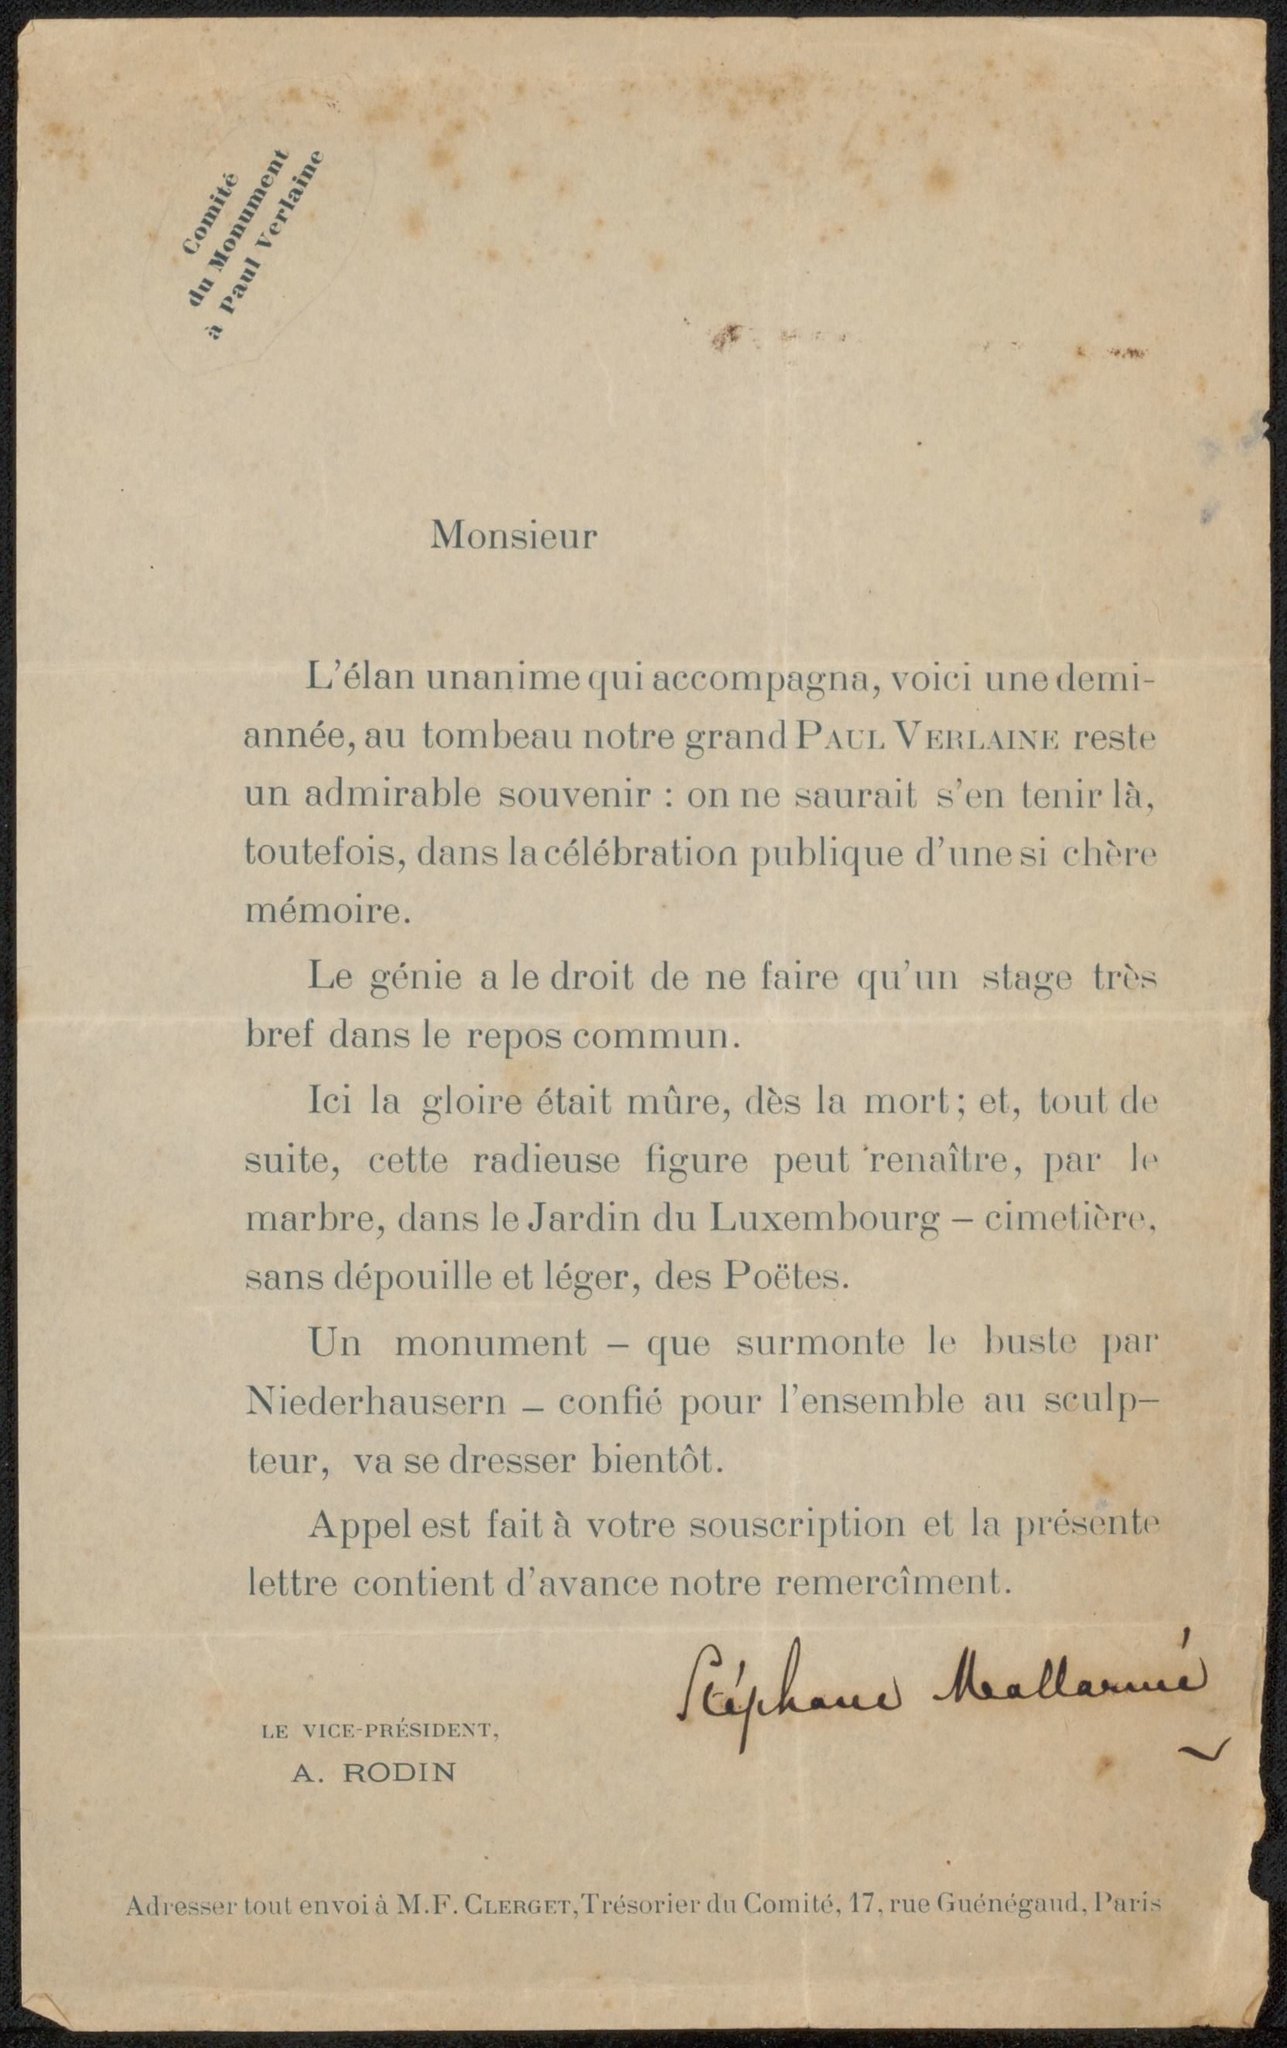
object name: letter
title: Brief aan Philip Zilcken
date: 1896-1898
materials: ink, paper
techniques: pen, printing, writing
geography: paris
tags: paul verlaine, the hague, philip zilcken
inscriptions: collector's mark: ‘RPK’